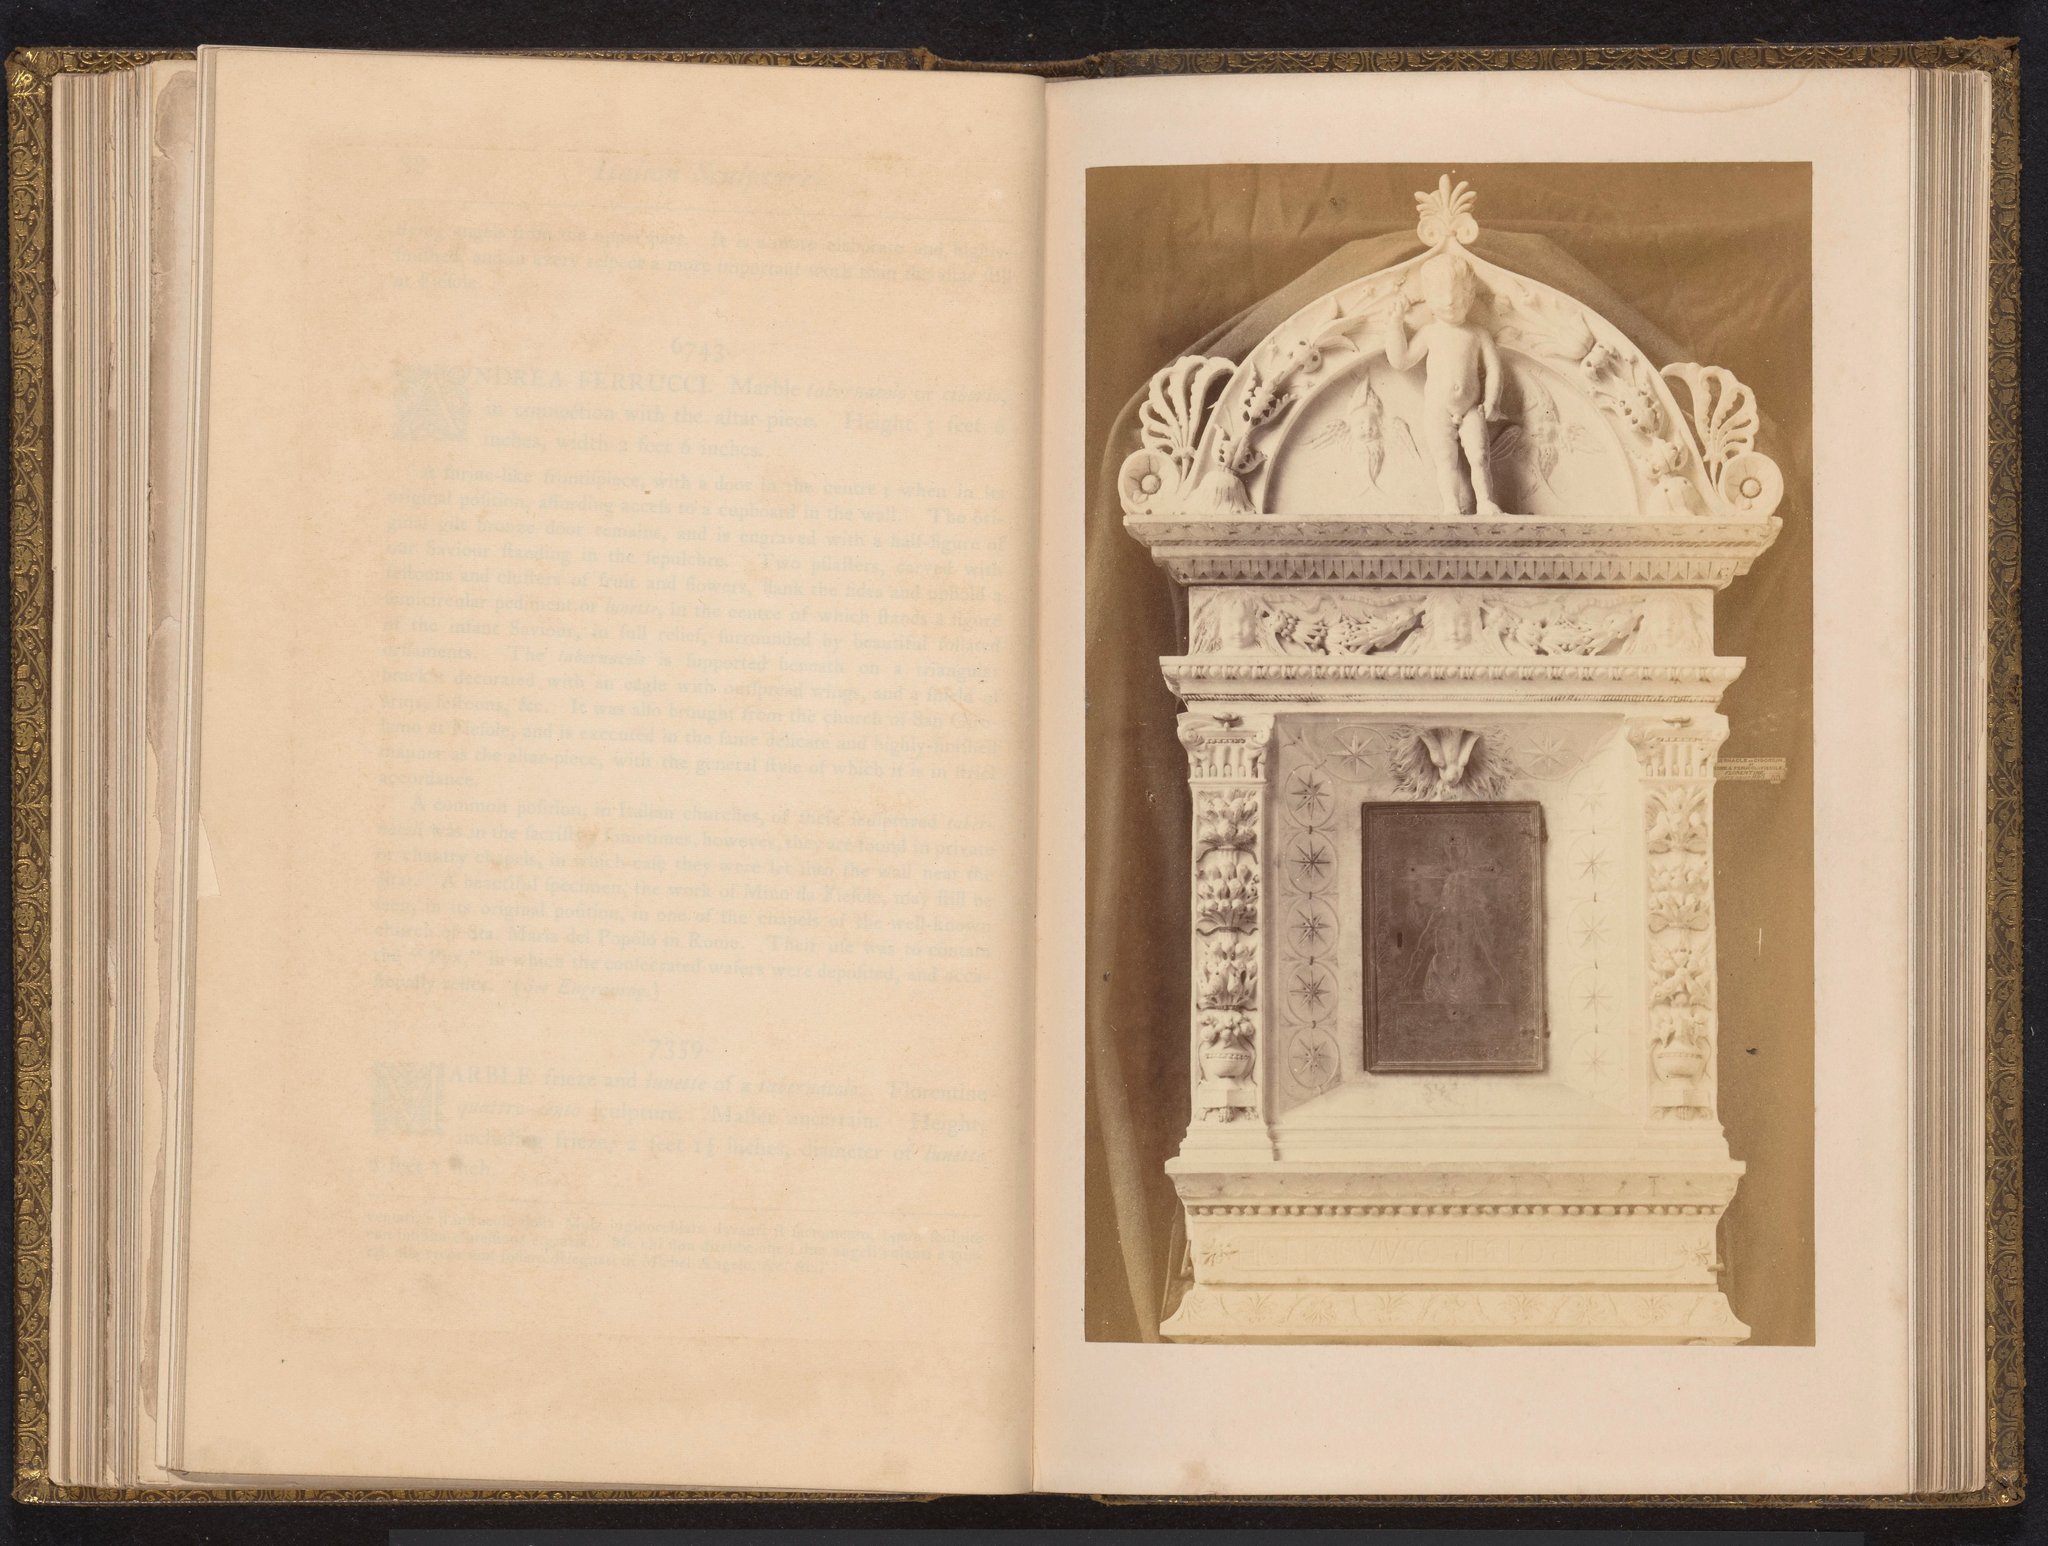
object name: page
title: Tabernakel gedecoreerd met Christus en een adelaar door Andrea Ferrucci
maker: Anonymous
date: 1852-1862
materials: photographic support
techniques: albumen print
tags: tabernacle elsewhere, sculpture (+ relief ~ sculpture)